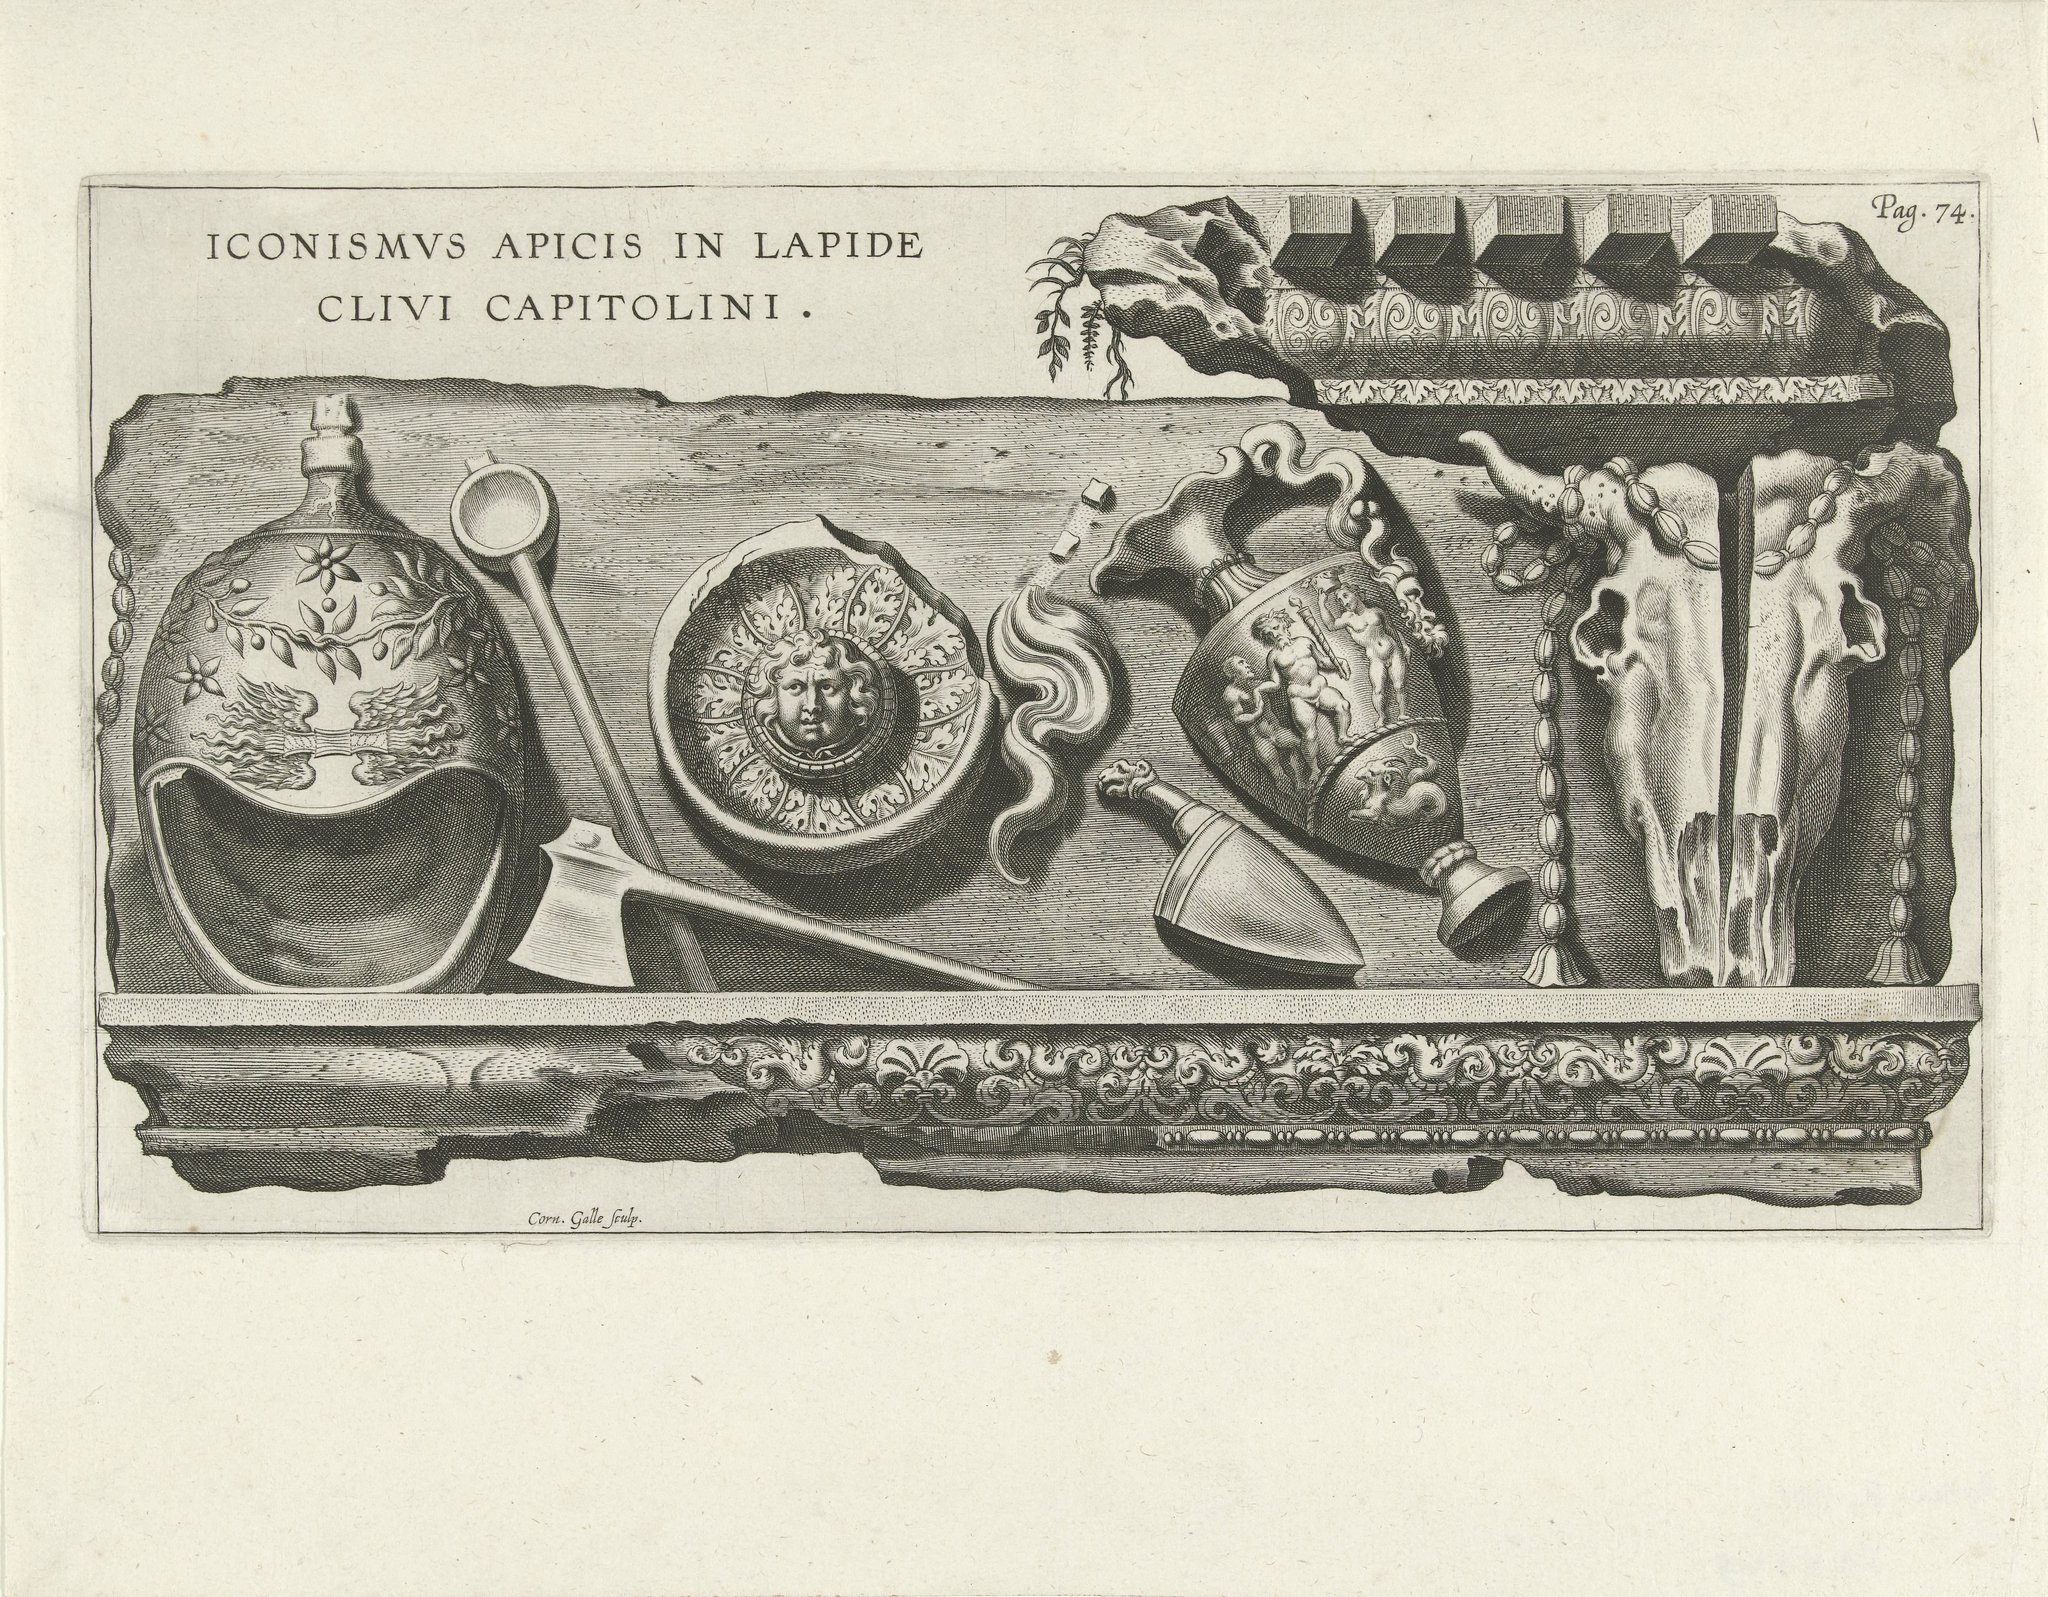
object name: book illustration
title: Iconismvs apicis in lapide clivi capitoloni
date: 1608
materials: paper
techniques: engraving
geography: antwerp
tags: piece of sculpture, reproduction of a piece of sculpture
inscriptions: collector's mark: Lugt 240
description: Deel van een antiek reliëf met gebruiksvoorwerpen. Van links naar rechts: een helm, een lepel, een bijl, een kom, een mes, een karaf en een versierde schedel van een koe met horens. Illustratie voor een boek over de Romeinse cultuur en geschiedenis.